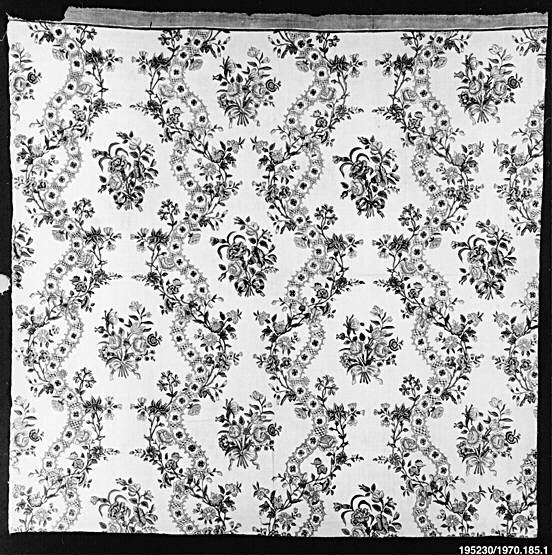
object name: piece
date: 1701-1800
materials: cotton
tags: flowers,leaves